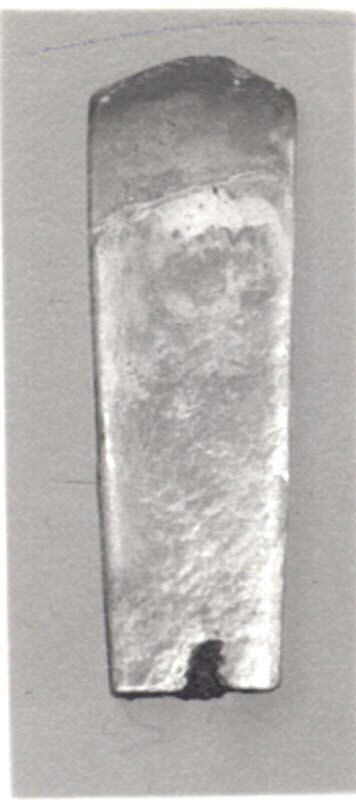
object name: handle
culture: sasanian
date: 201-700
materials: shell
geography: iran